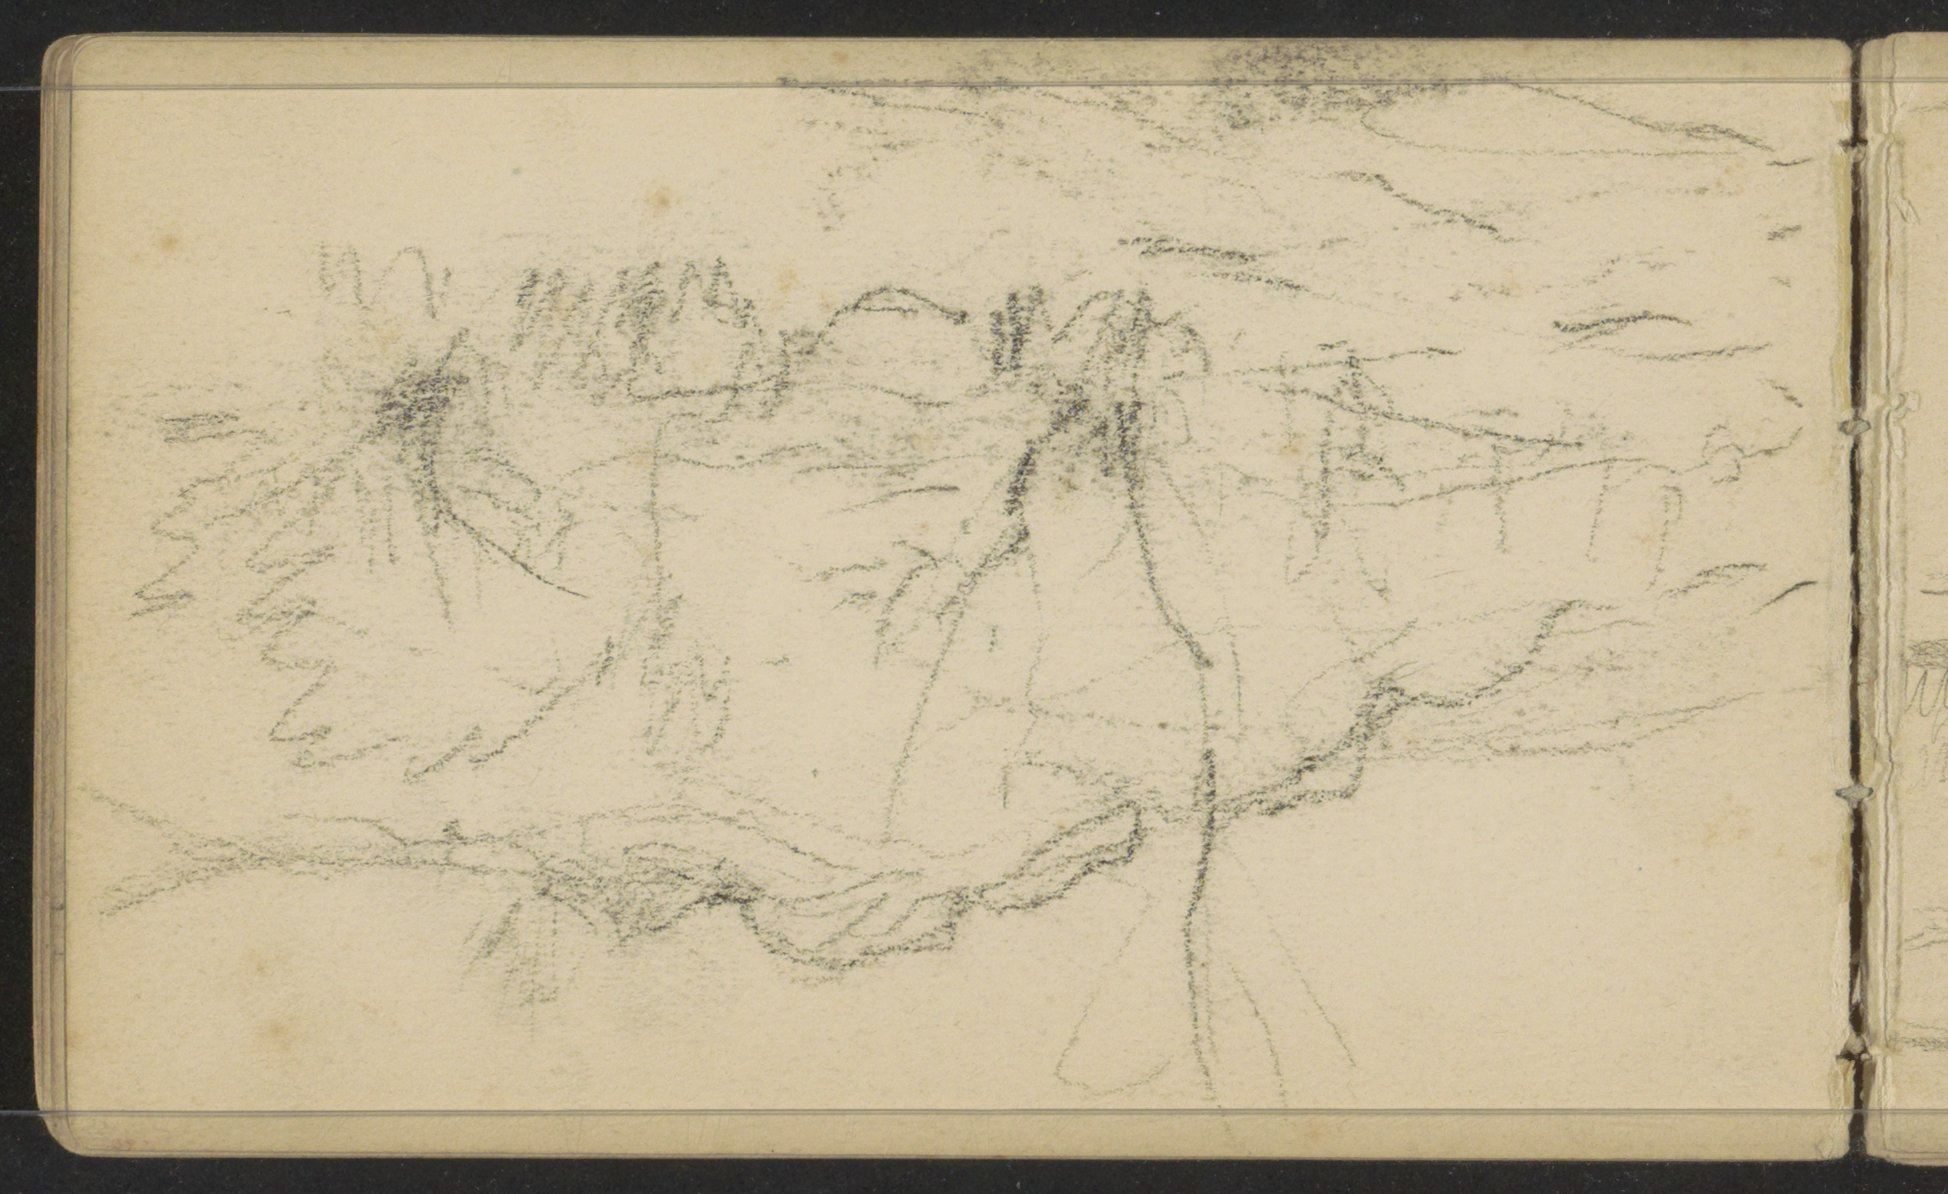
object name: sketchbook leaf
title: Heuvel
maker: willem cornelis rip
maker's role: draughtsman, painter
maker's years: 1856-1922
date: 1892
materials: chalk, paper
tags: (high) hill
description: Blad 18 verso uit een schetsboek met 25 bladen.